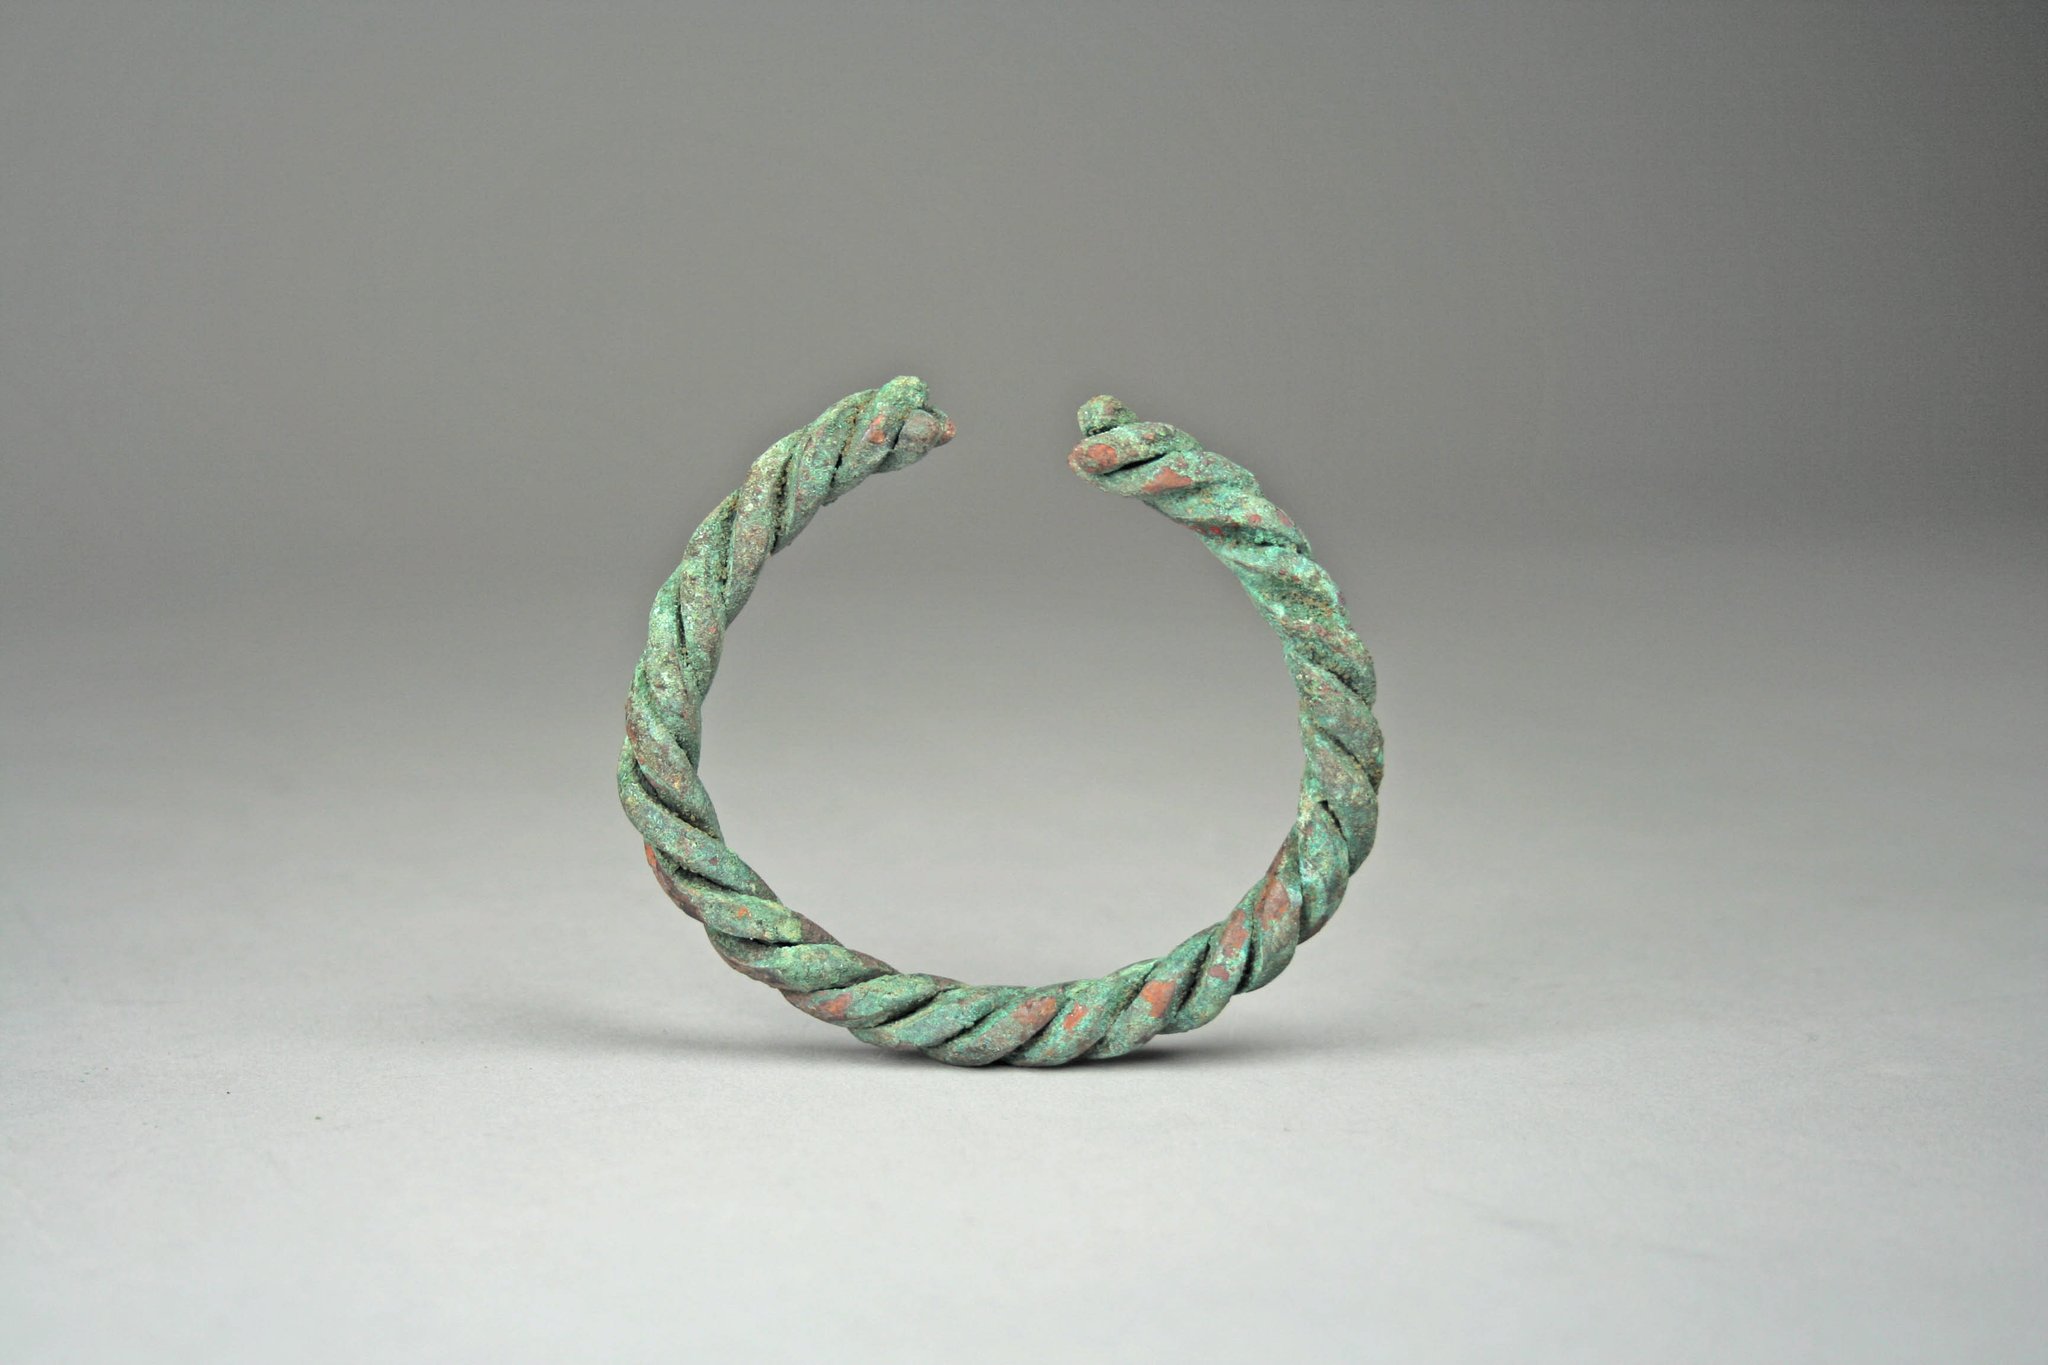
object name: bracelet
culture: middle niger civilization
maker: middle niger artist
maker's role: artist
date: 1301-1400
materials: copper alloy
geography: mali